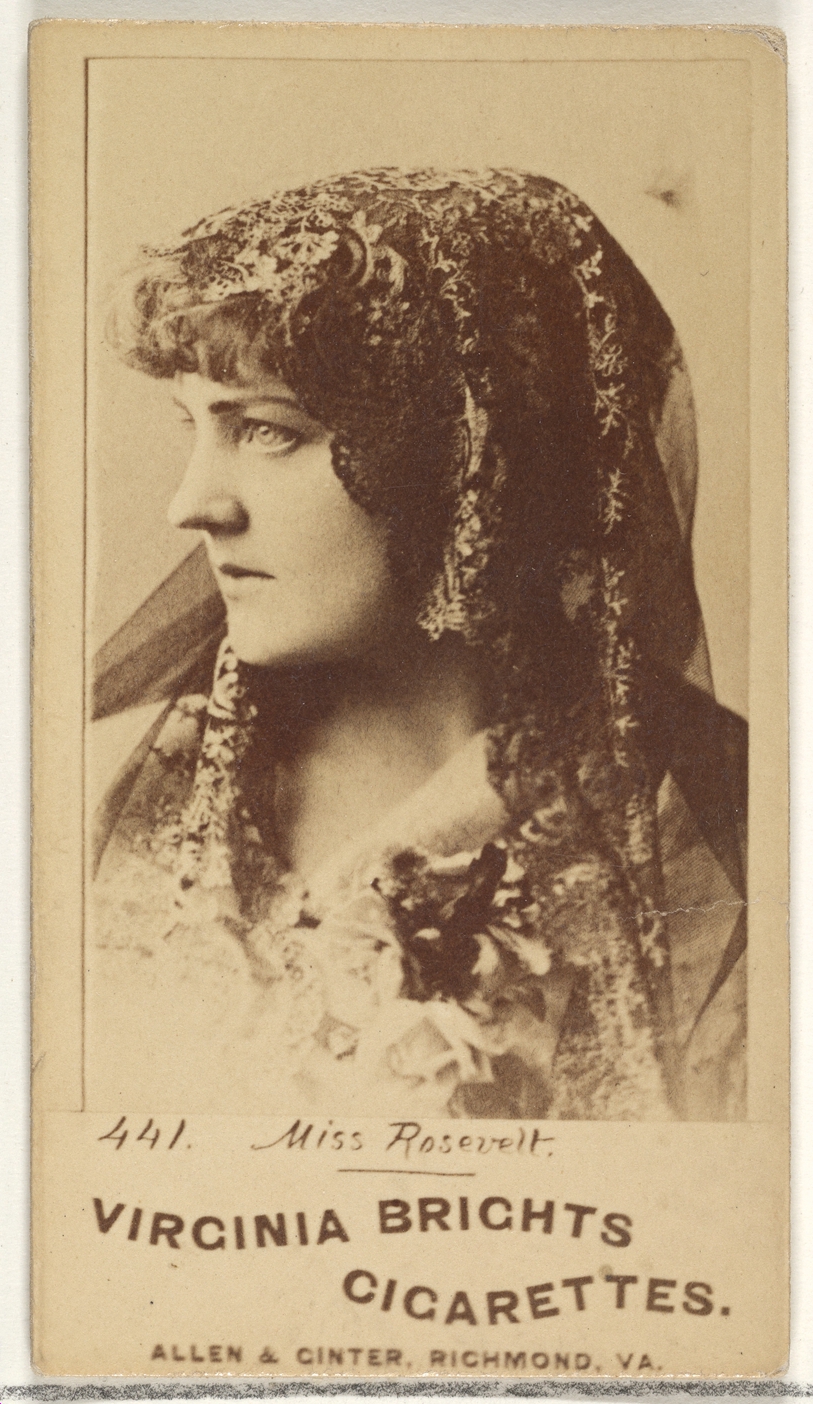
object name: photograph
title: Card 441, Miss Rosevelt, from the Actors and Actresses series (N45, Type 1) for Virginia Brights Cigarettes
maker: allen & ginter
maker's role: publisher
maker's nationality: american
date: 1888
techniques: albumen silver print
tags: portraits,women,actresses